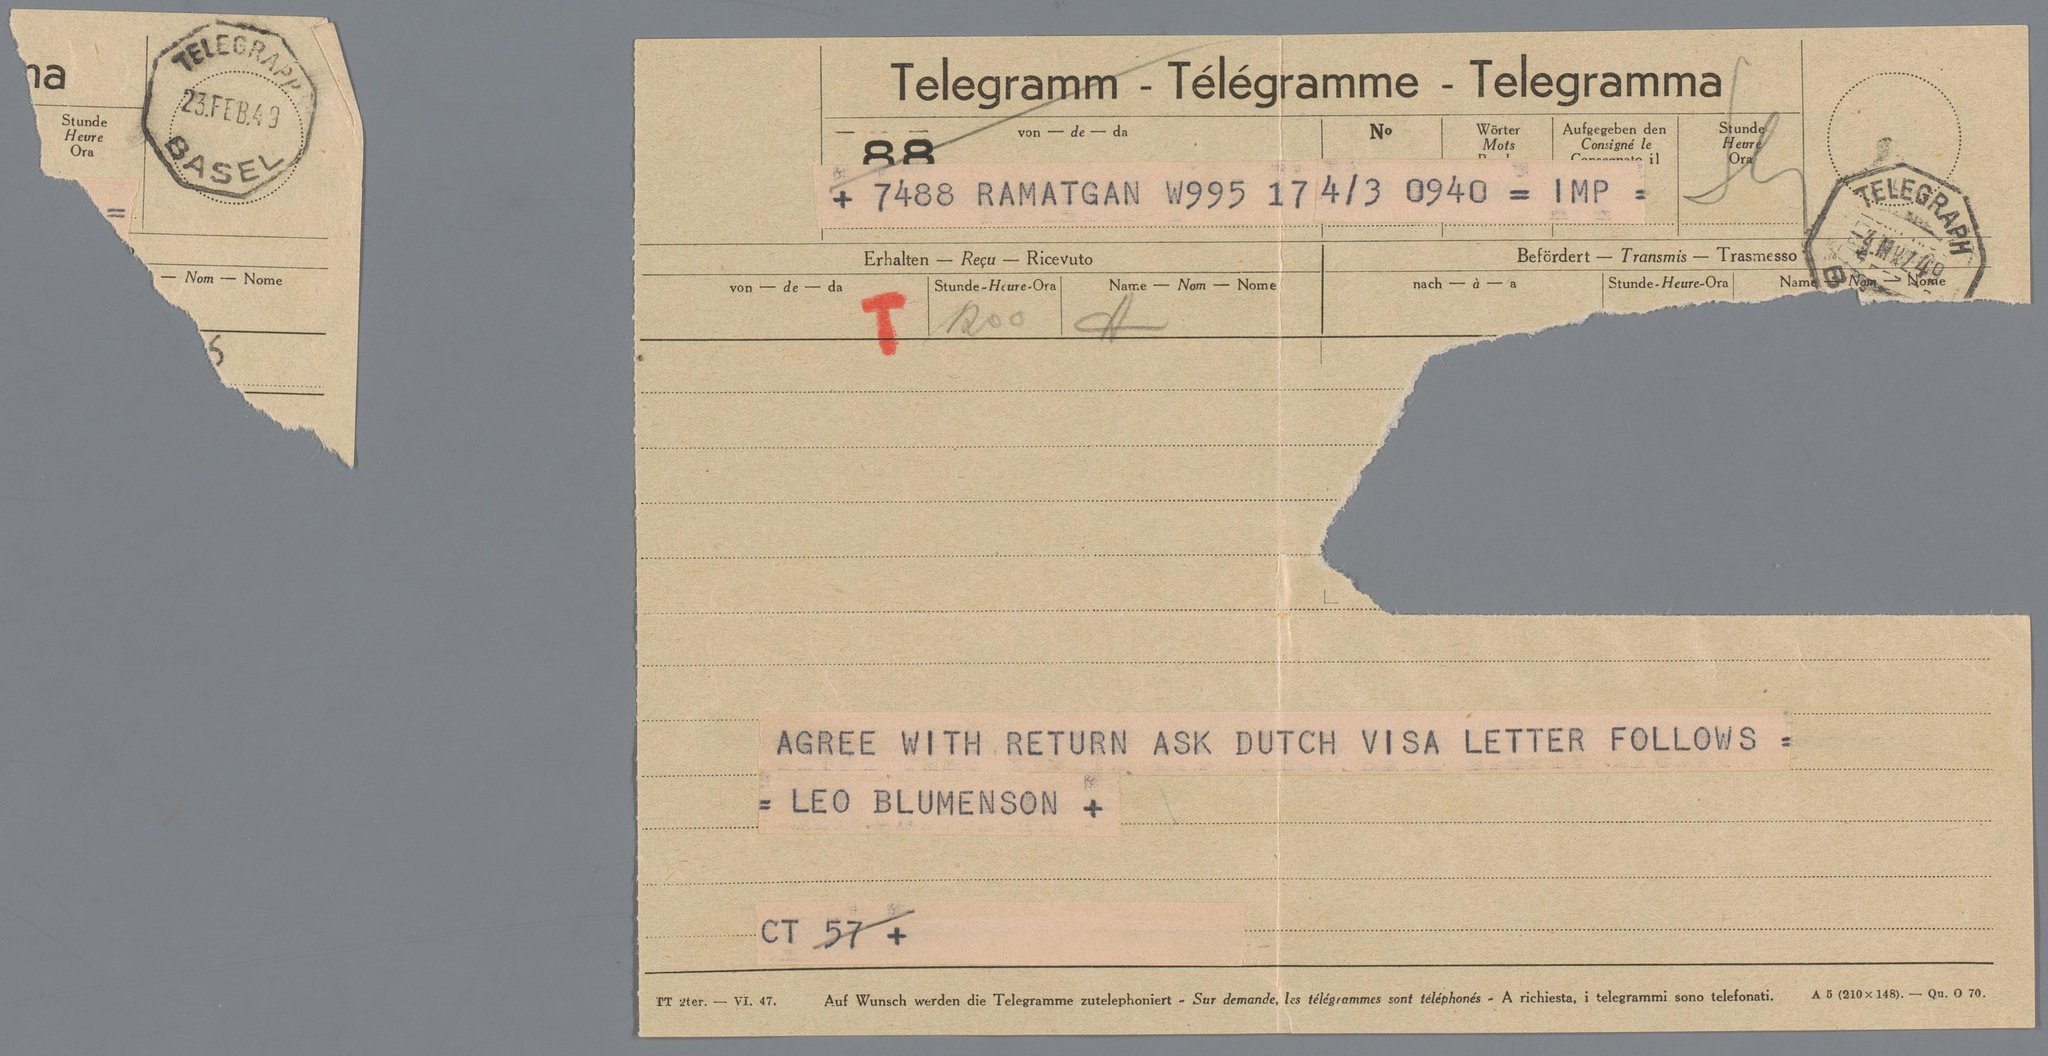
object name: telegram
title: Belangrijke brieven met betrekking tot het leven van Isabel Wachenheimer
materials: paper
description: Dit object is onderdeel van de nalatenschap van Isabel Elon-Wachenheimer (1928-2010). Tot haar overlijden behoorde het samen met de andere objecten uit de nalatenschap tot haar privédomein van Isabel Wachenheimer. In die particuliere context zijn deze objecten tezamen en individueel aandenkens - aan de jeugd, ouders en familie van Isabel Wachenheimer vóór en tijdens de Shoah en aan haar leven na de Tweede Wereldoorlog. Isabel Wachenheimer, die van juni 1943 tot mei 1945 gevangen zat in Kamp Westerbork, Theresienstadt, Auschwitz, Lenzing a/d Oberdonau (een buitenkamp van Mauthausen), overleefde de Shoah. Haar ouders – Eugène Wachenheimer en Else Wachenheimer-Moos - werden op 14 oktober 1944 in Auschwitz-Birkenau vermoord.